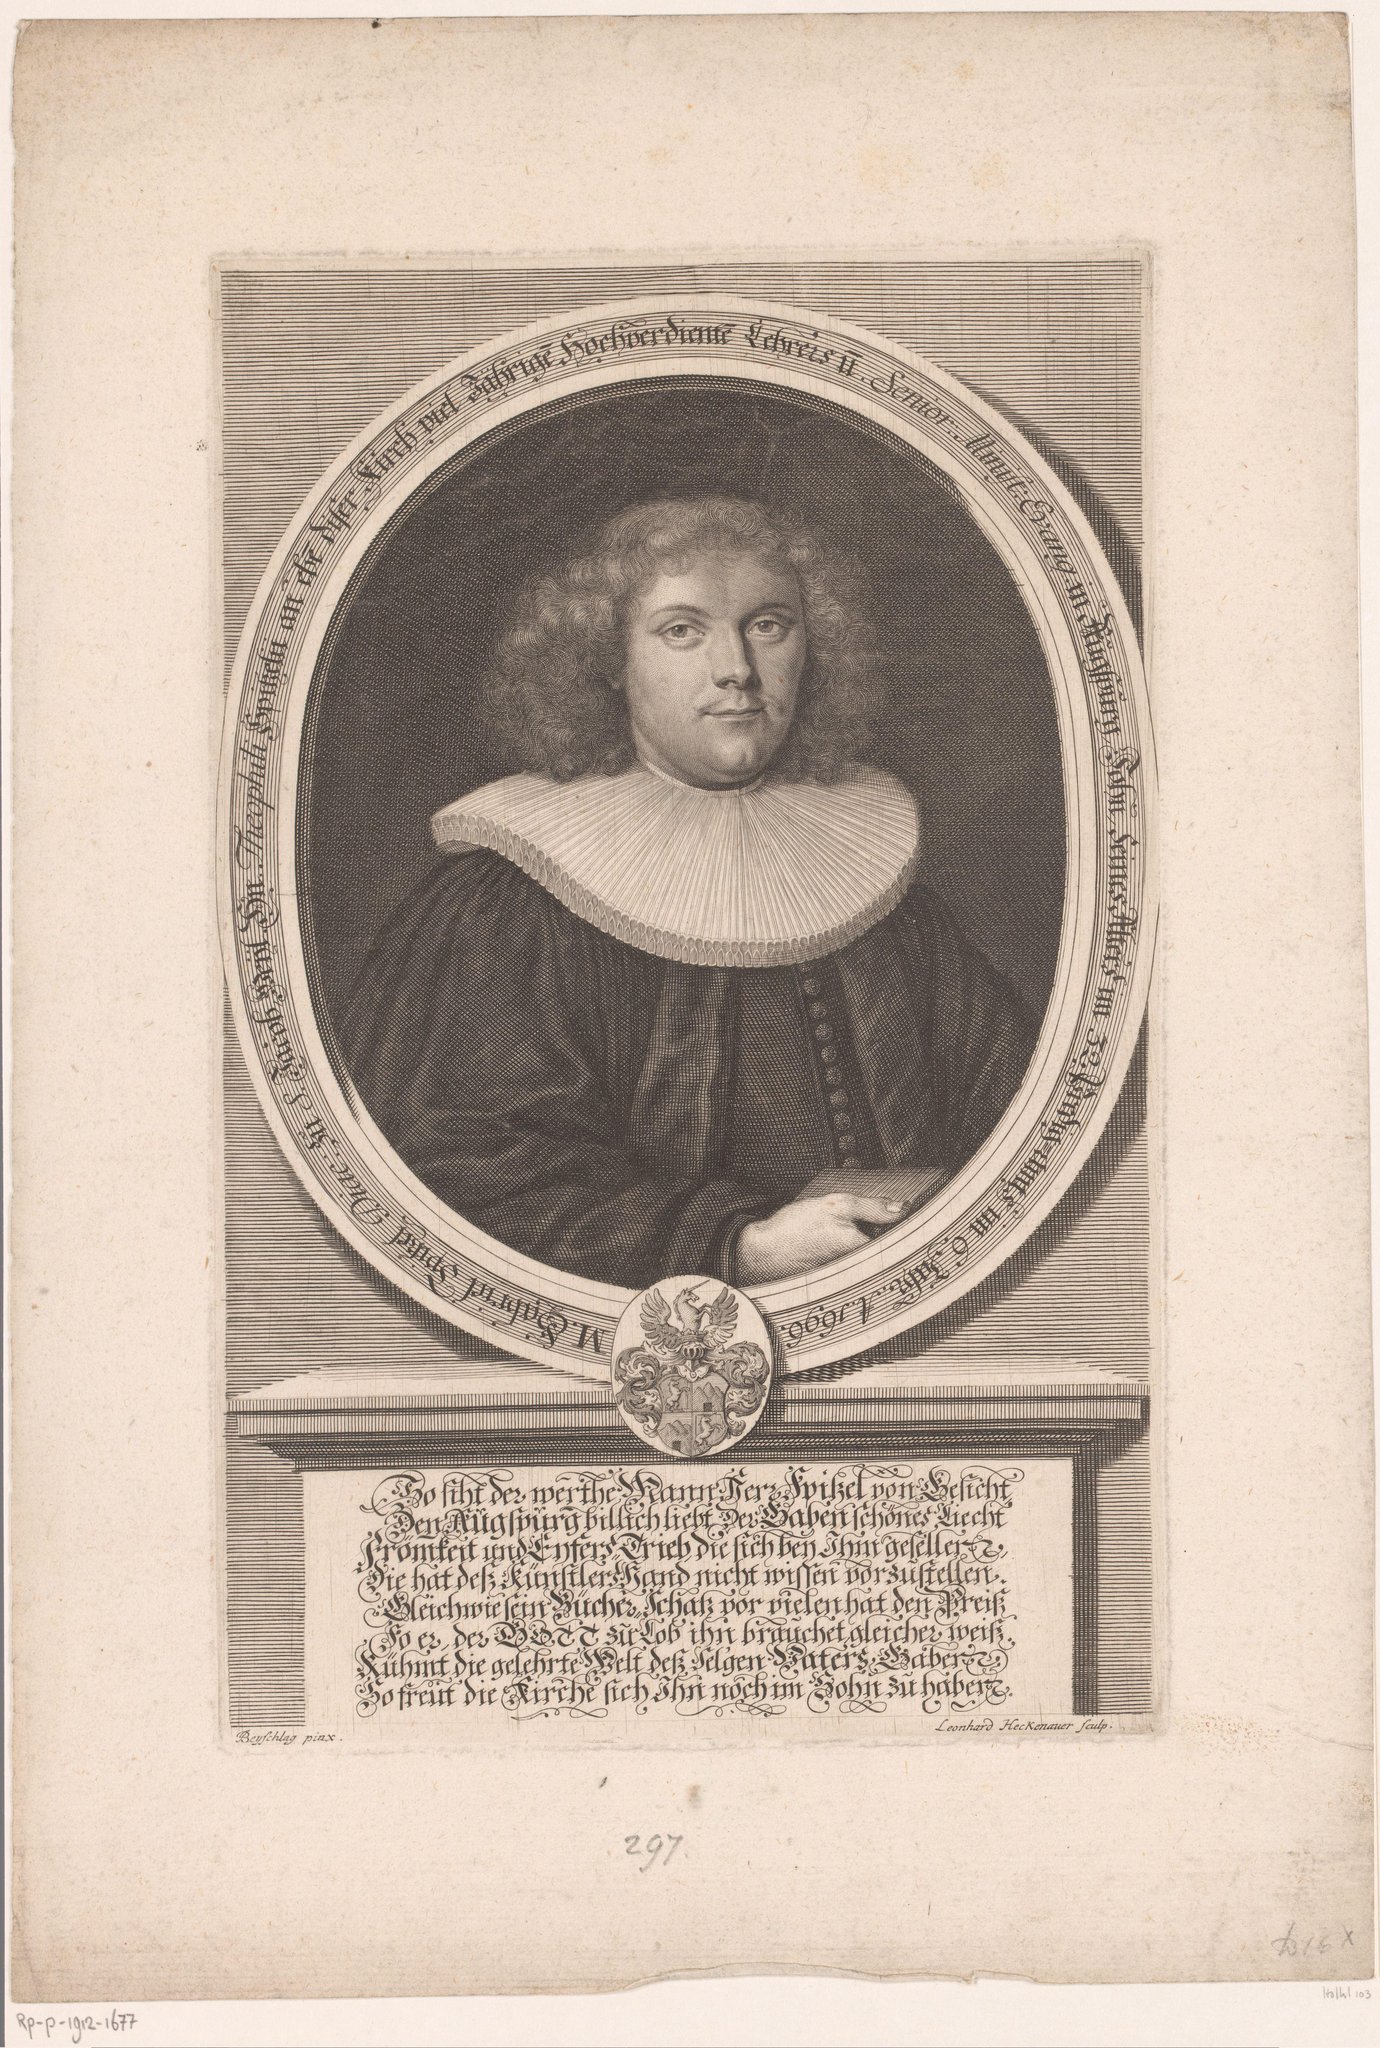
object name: print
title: Portret van Gabriel Spitzel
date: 1696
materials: paper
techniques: engraving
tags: historical persons, book, armorial bearing, heraldry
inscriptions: collector's mark: Lugt 2228